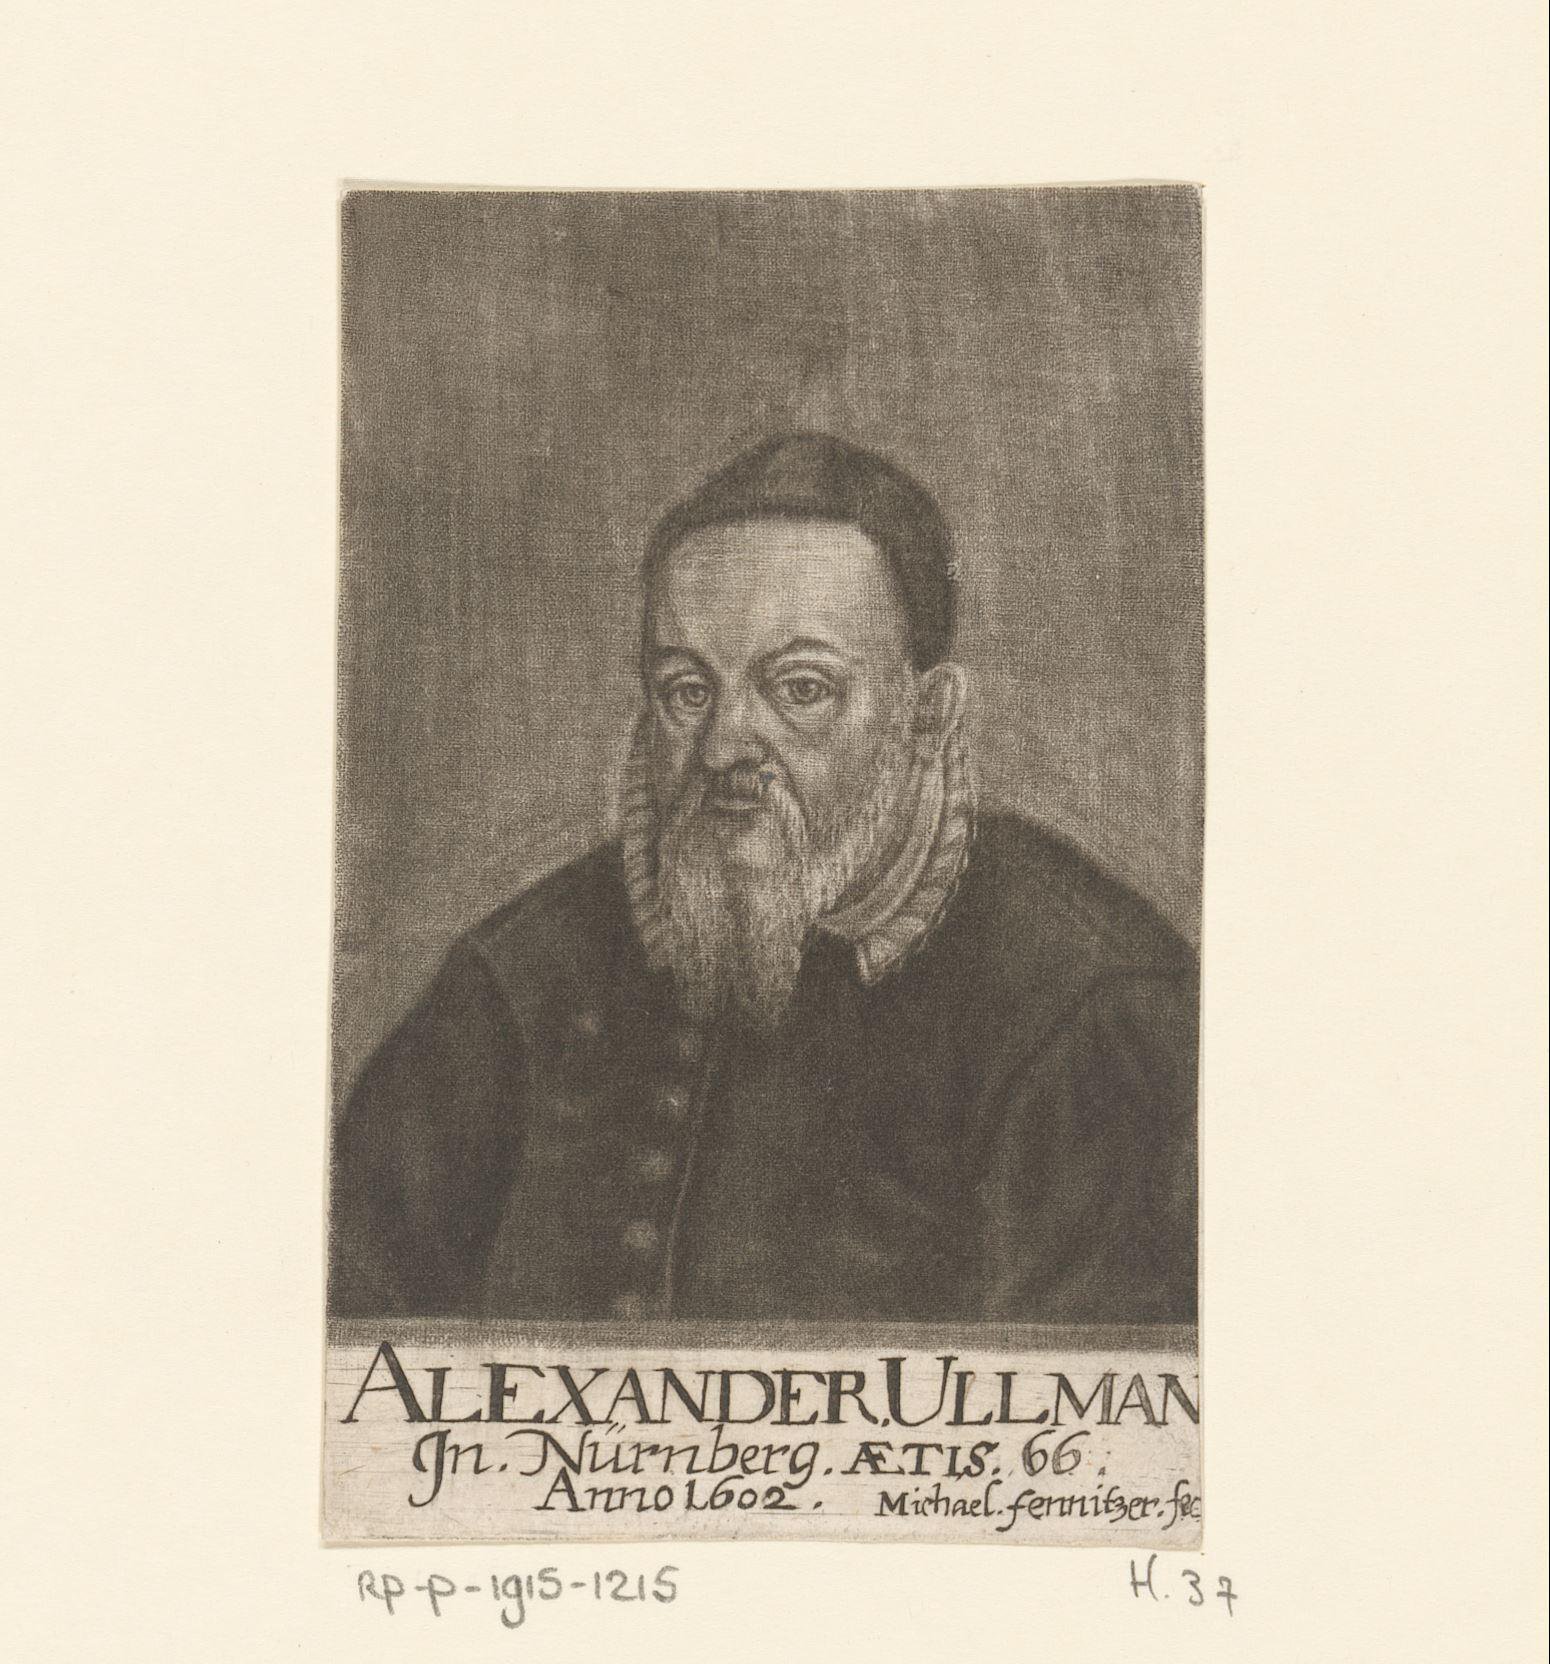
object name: print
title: Portret van Alexander Ullmann op 66-jarige leeftijd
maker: michael fennitzer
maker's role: print maker, printer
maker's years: 1641-1702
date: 1651-1702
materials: paper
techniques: mezzotint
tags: historical persons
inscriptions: collector's mark: Lugt 2228